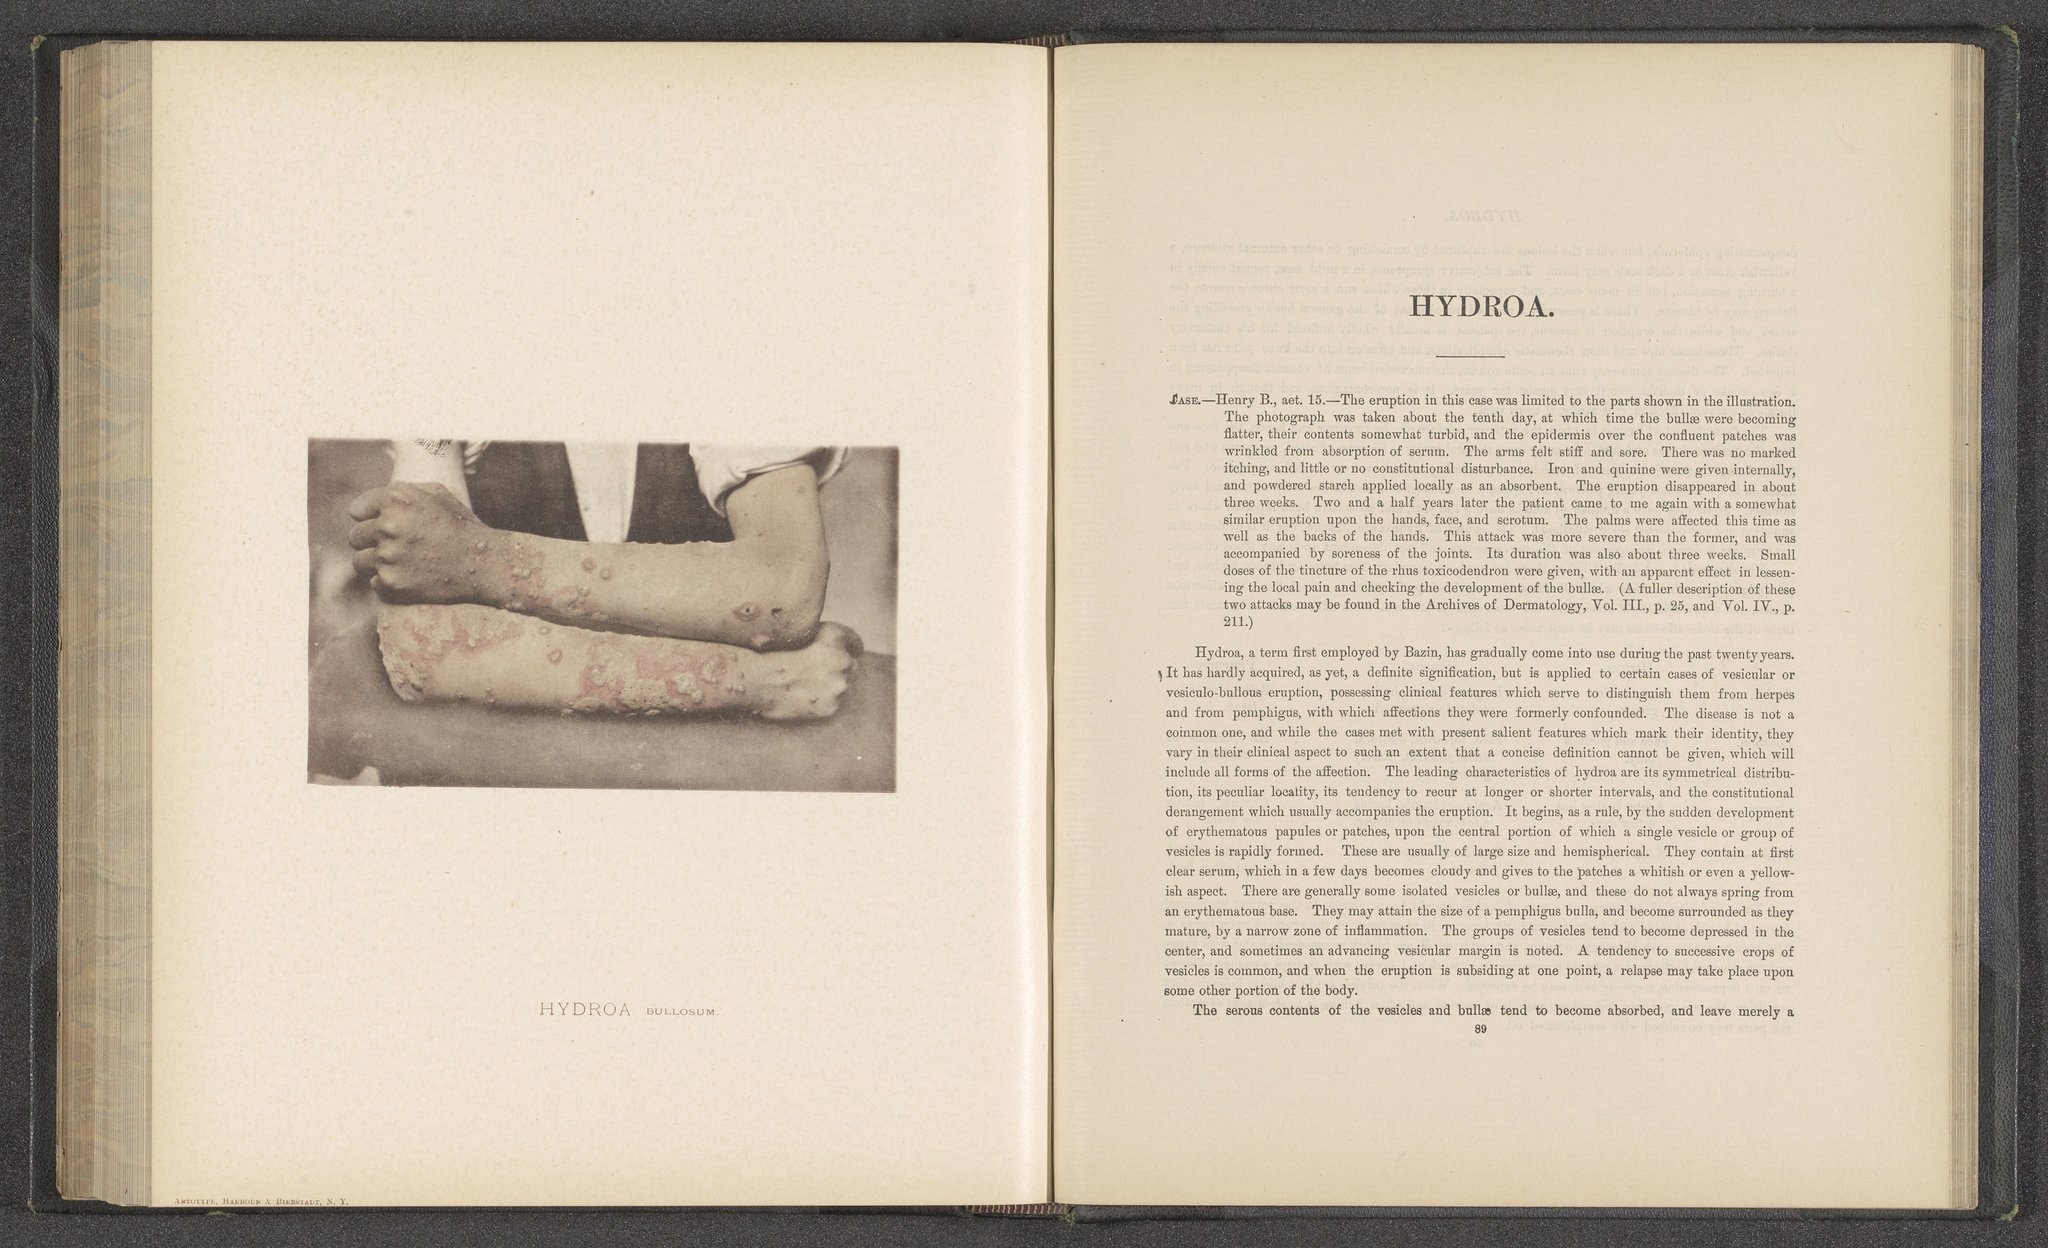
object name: photomechanical print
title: Hydroa bullosum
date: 1870-1881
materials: paper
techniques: photograph, hand coloring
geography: new york city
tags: skin and venereal diseases, arms